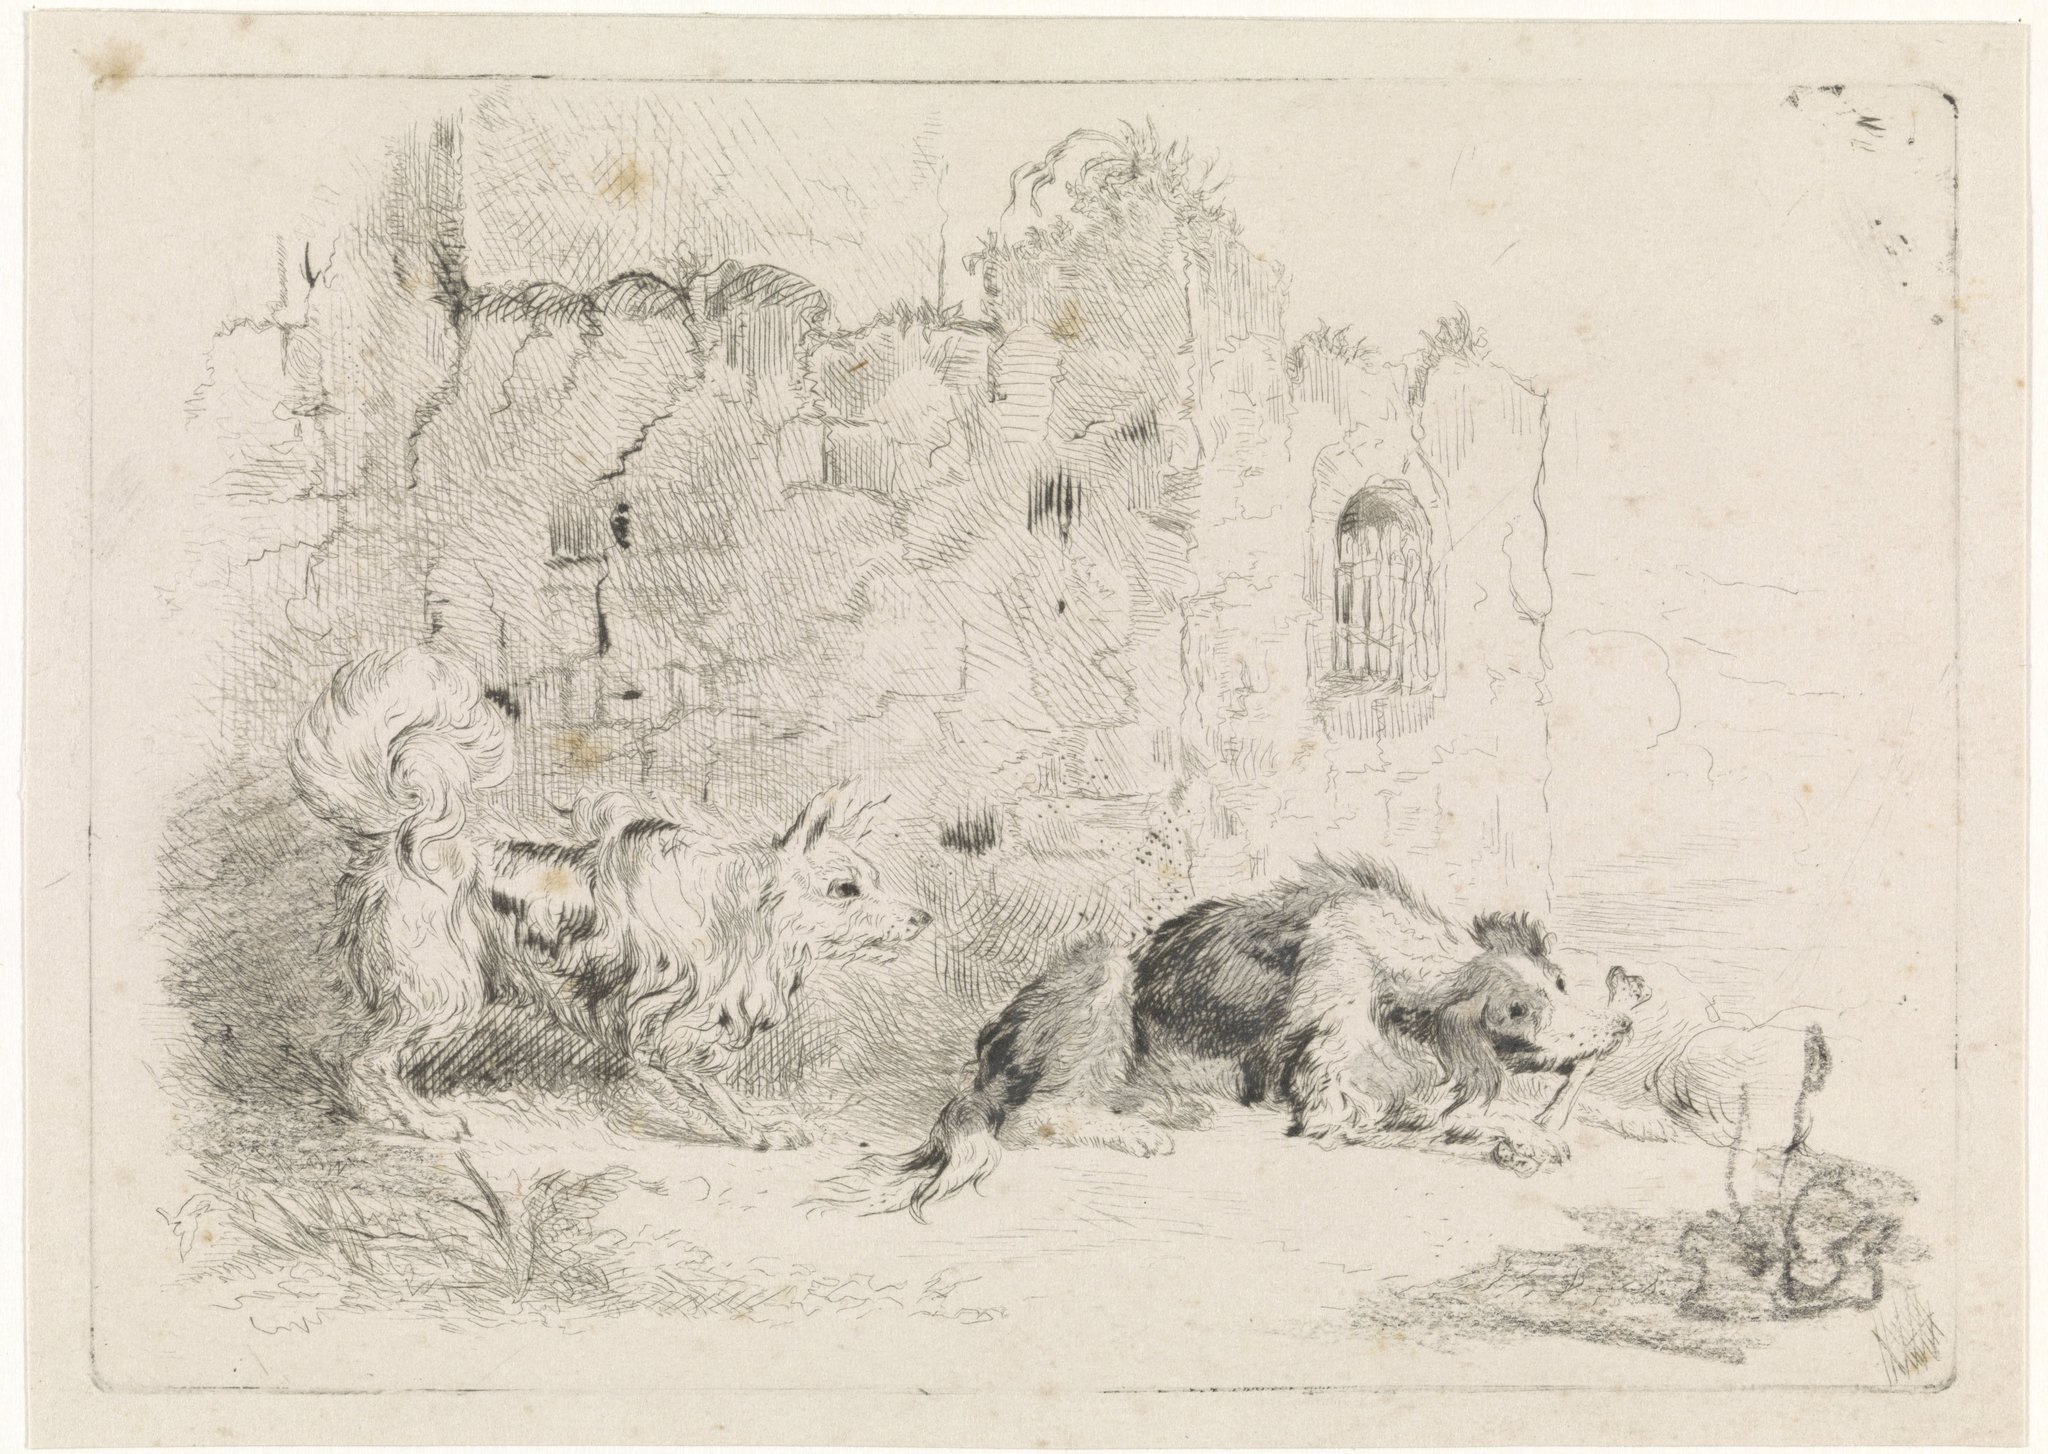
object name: print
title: Twee honden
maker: jan karel jacob de jonge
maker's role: draughtsman, print maker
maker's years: 1828-1880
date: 1851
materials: chalk, paper, pencil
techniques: drypoint, etching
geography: the hague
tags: landscape with ruins, dog with bone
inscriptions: collector's mark: Lugt 2228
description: Landschap met ruïne en twee honden, één van hen kluift op een bot.